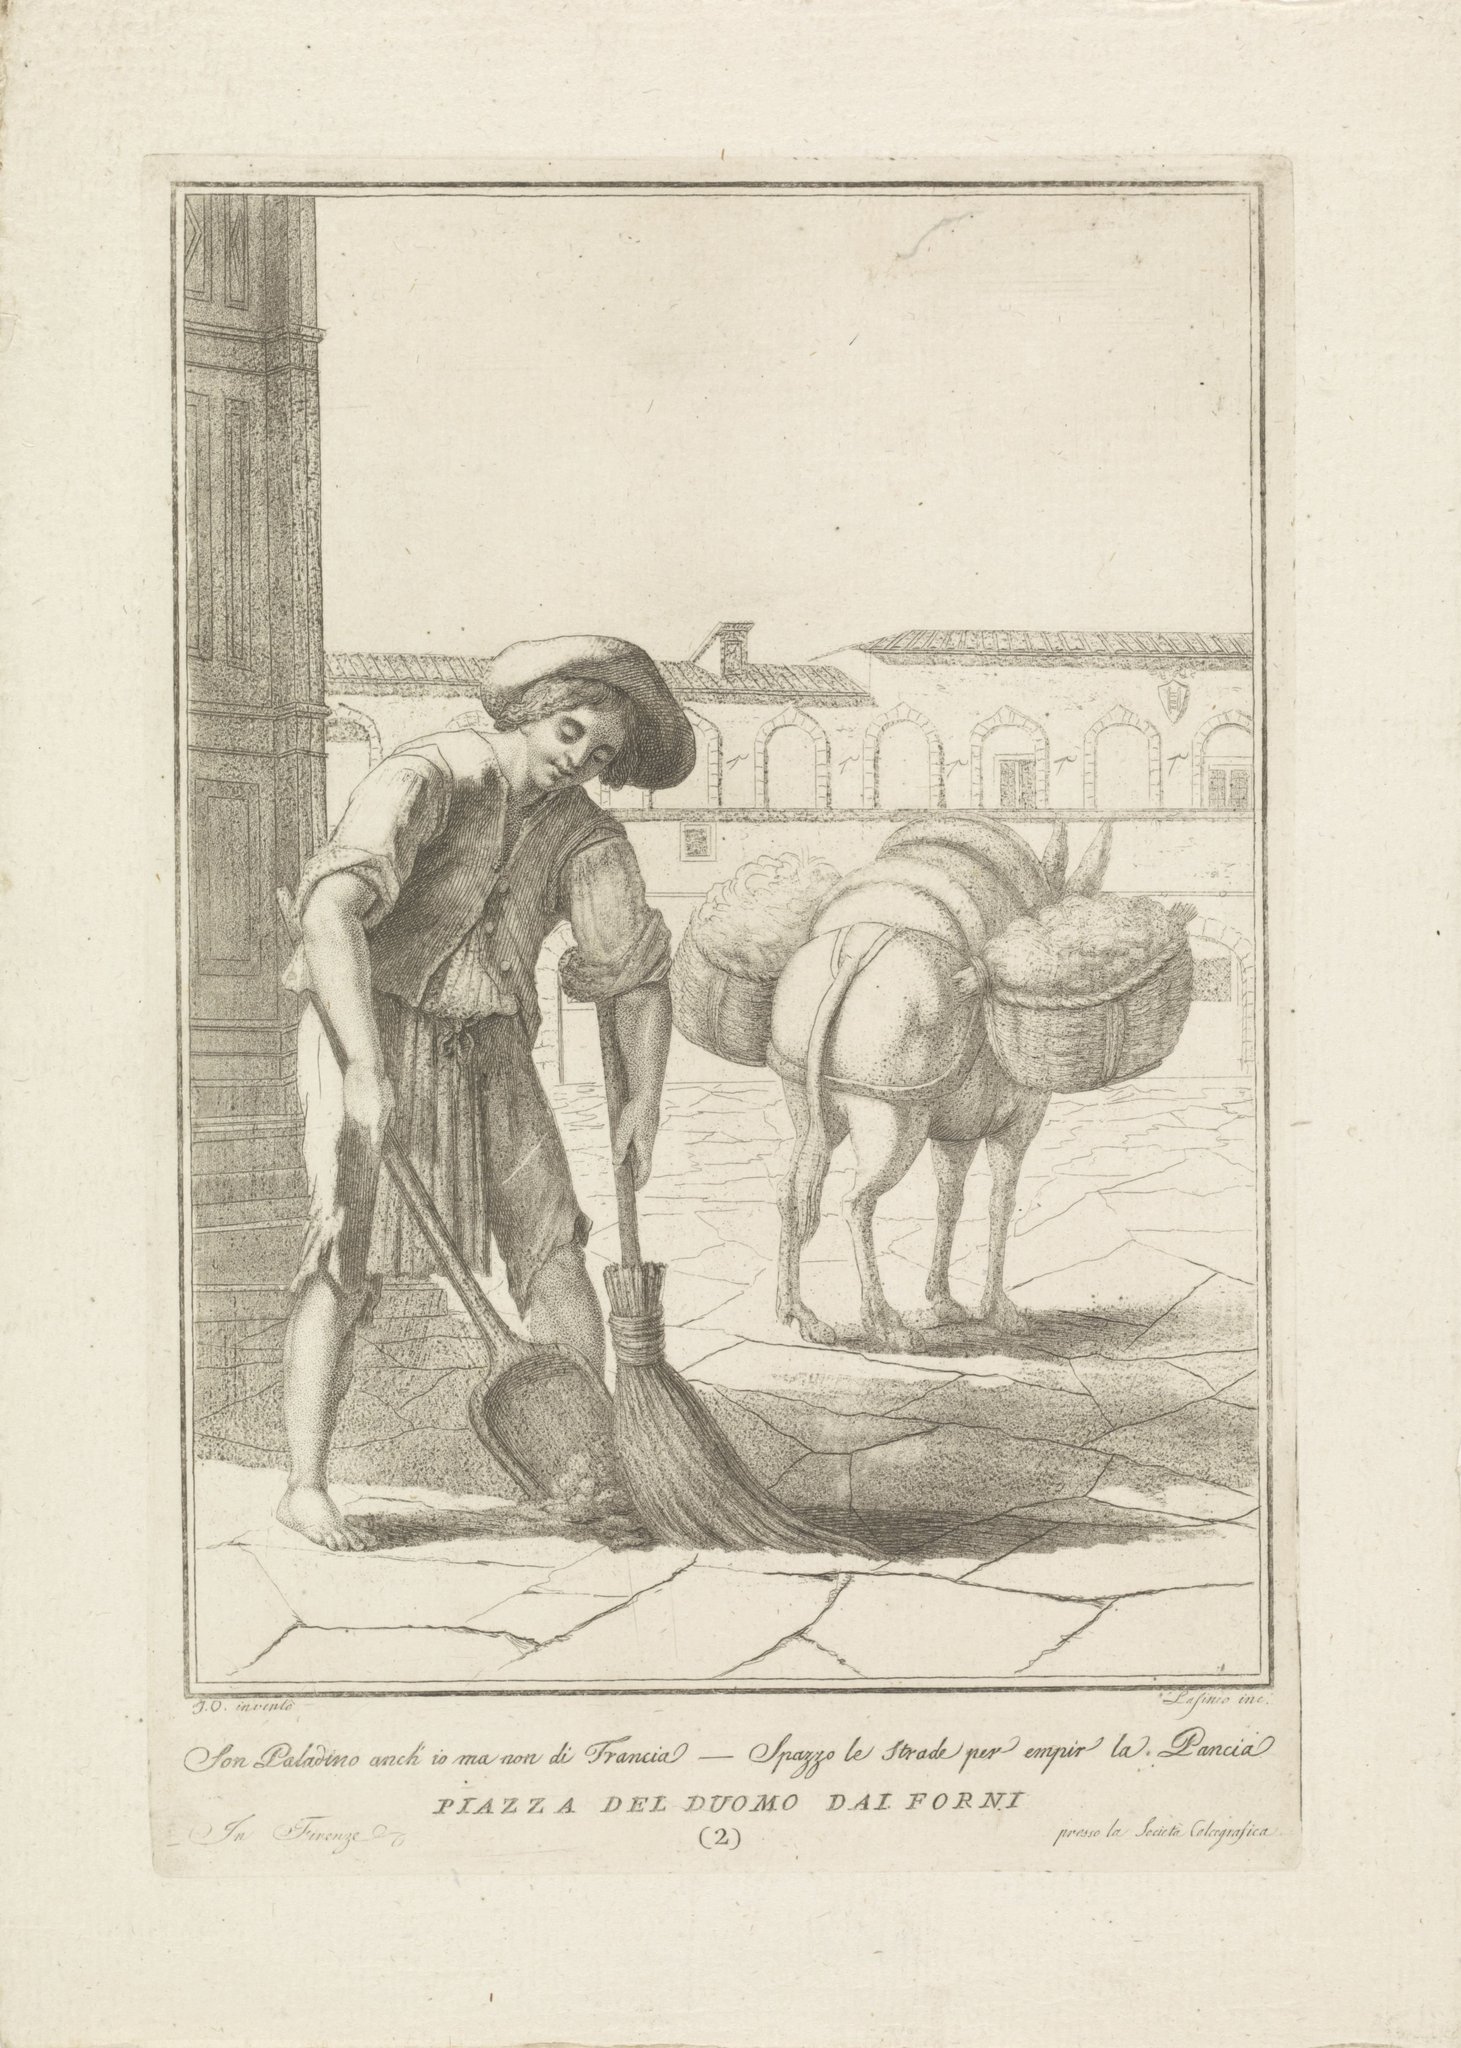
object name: print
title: Florentijnse straatventers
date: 1769-1838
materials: paper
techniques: etching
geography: florence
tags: ass, donkey, street sweeping, street sweeper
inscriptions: collector's mark: Lugt 2228, collector's mark: Lugt 2760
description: Een straatveger veegt vuil met zijn bezem op een schep op het Piazza del Duomo te Florence. Op het plein een ezel met twee manden. Italiaanse tekst in ondermarge.